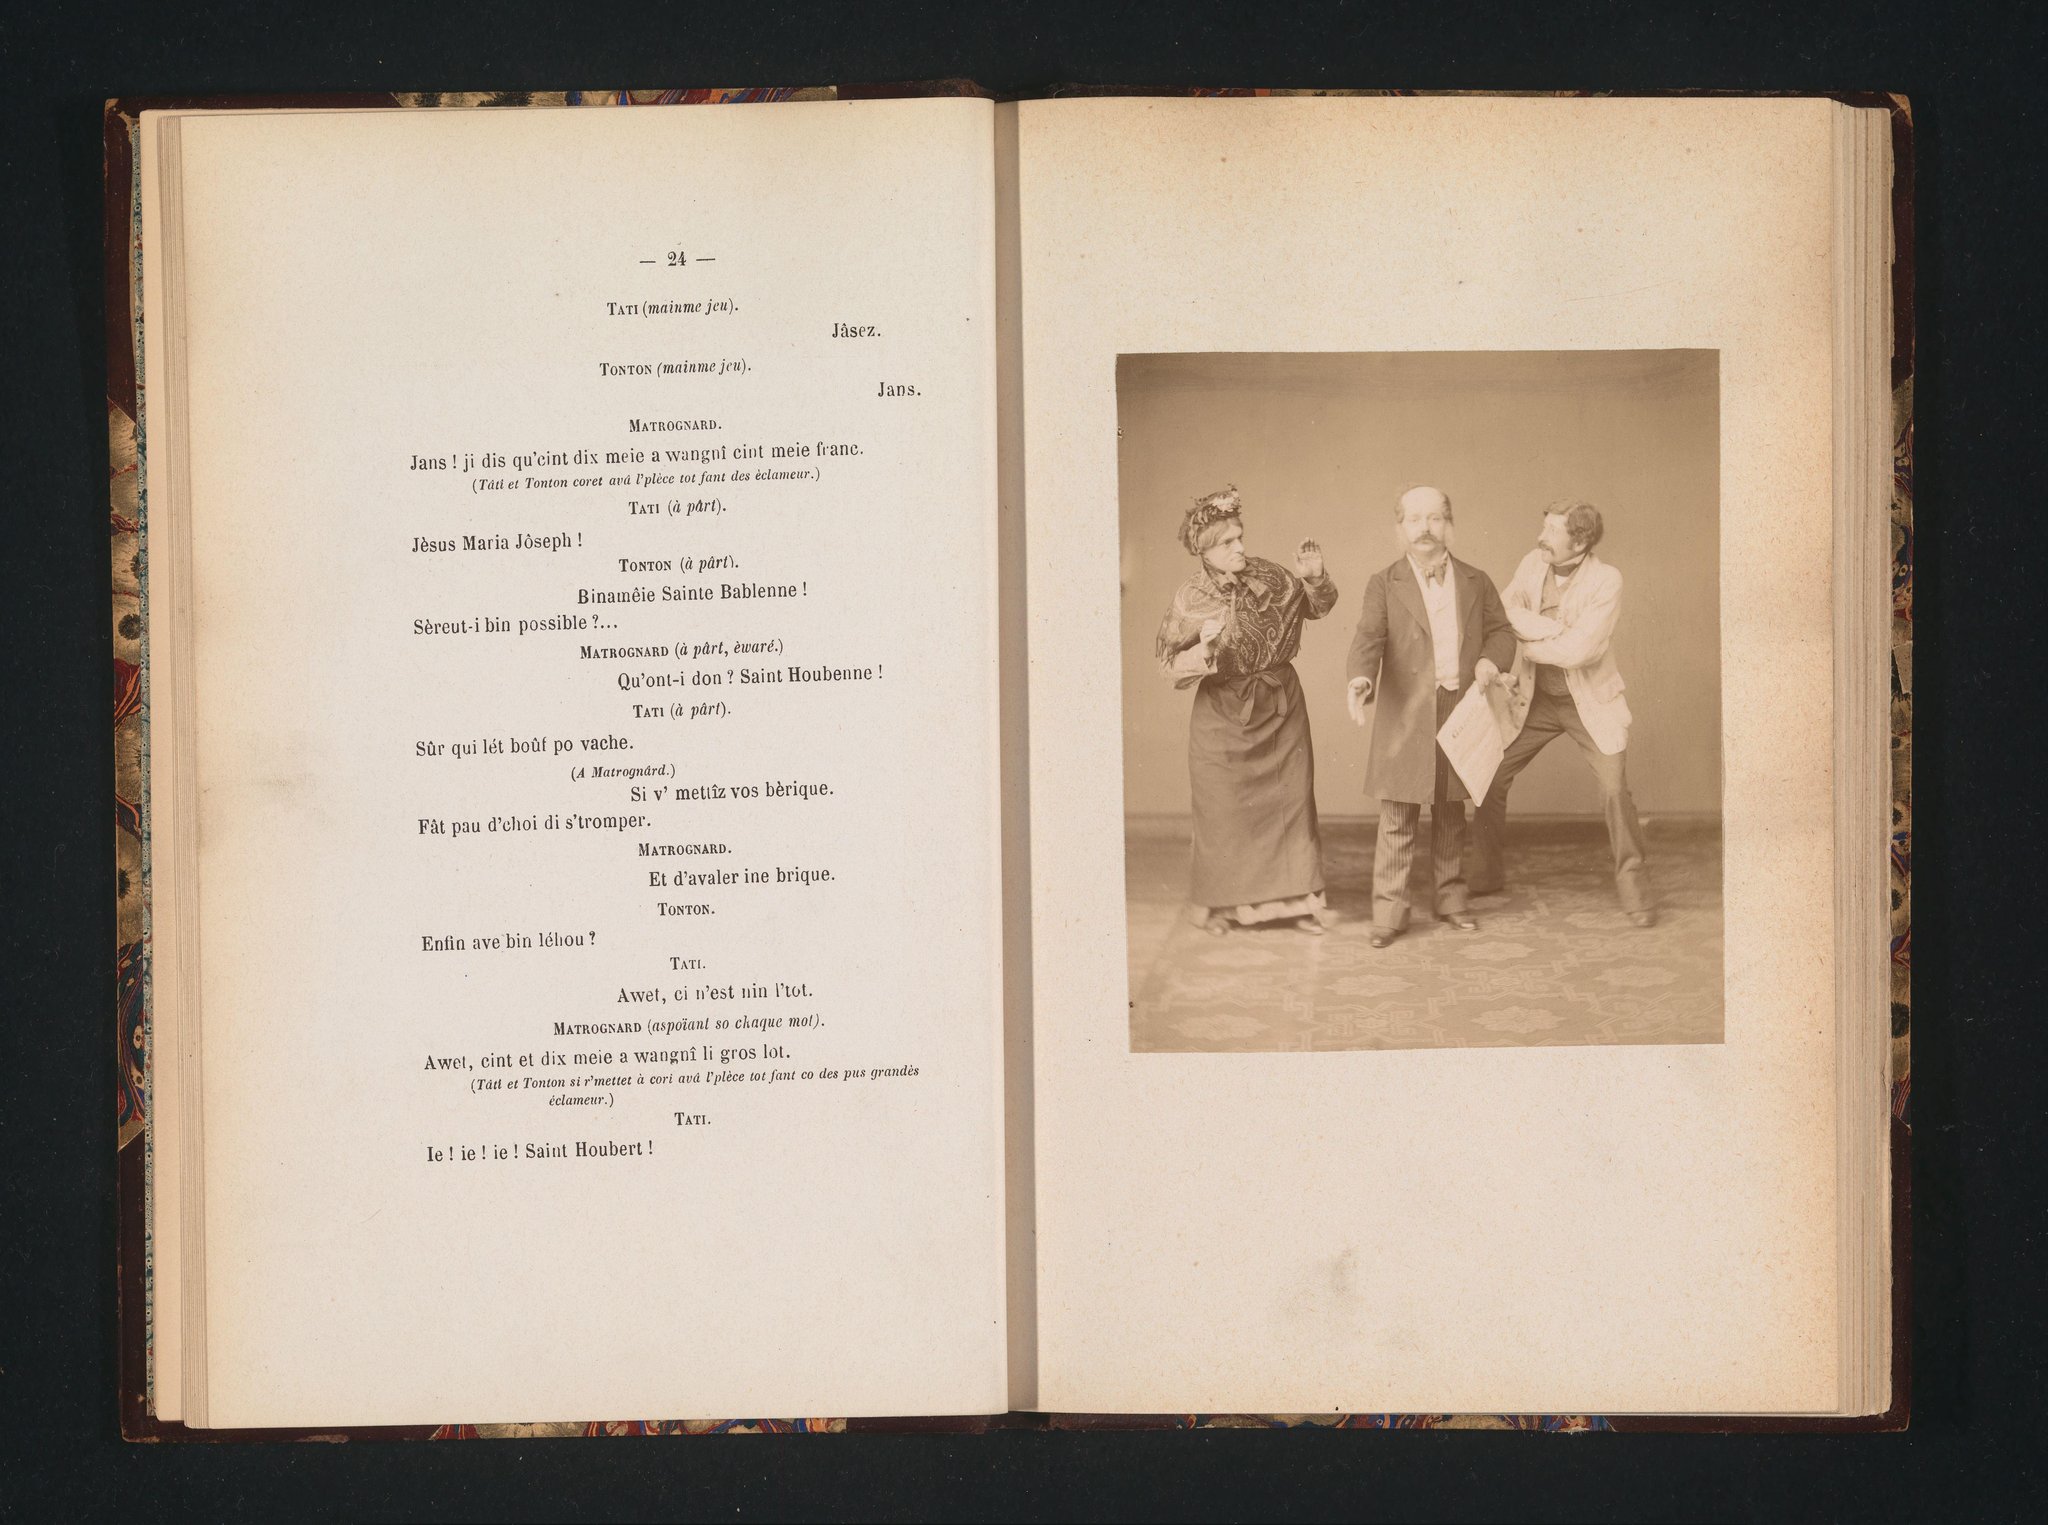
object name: page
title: Scène uit het theaterstuk Tati l'perriqui met twee mannen en een vrouw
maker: Anonymous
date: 1888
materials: photographic support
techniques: albumen print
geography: liège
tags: theatre, theatrical performance, actress (on the stage), actor (on the stage)